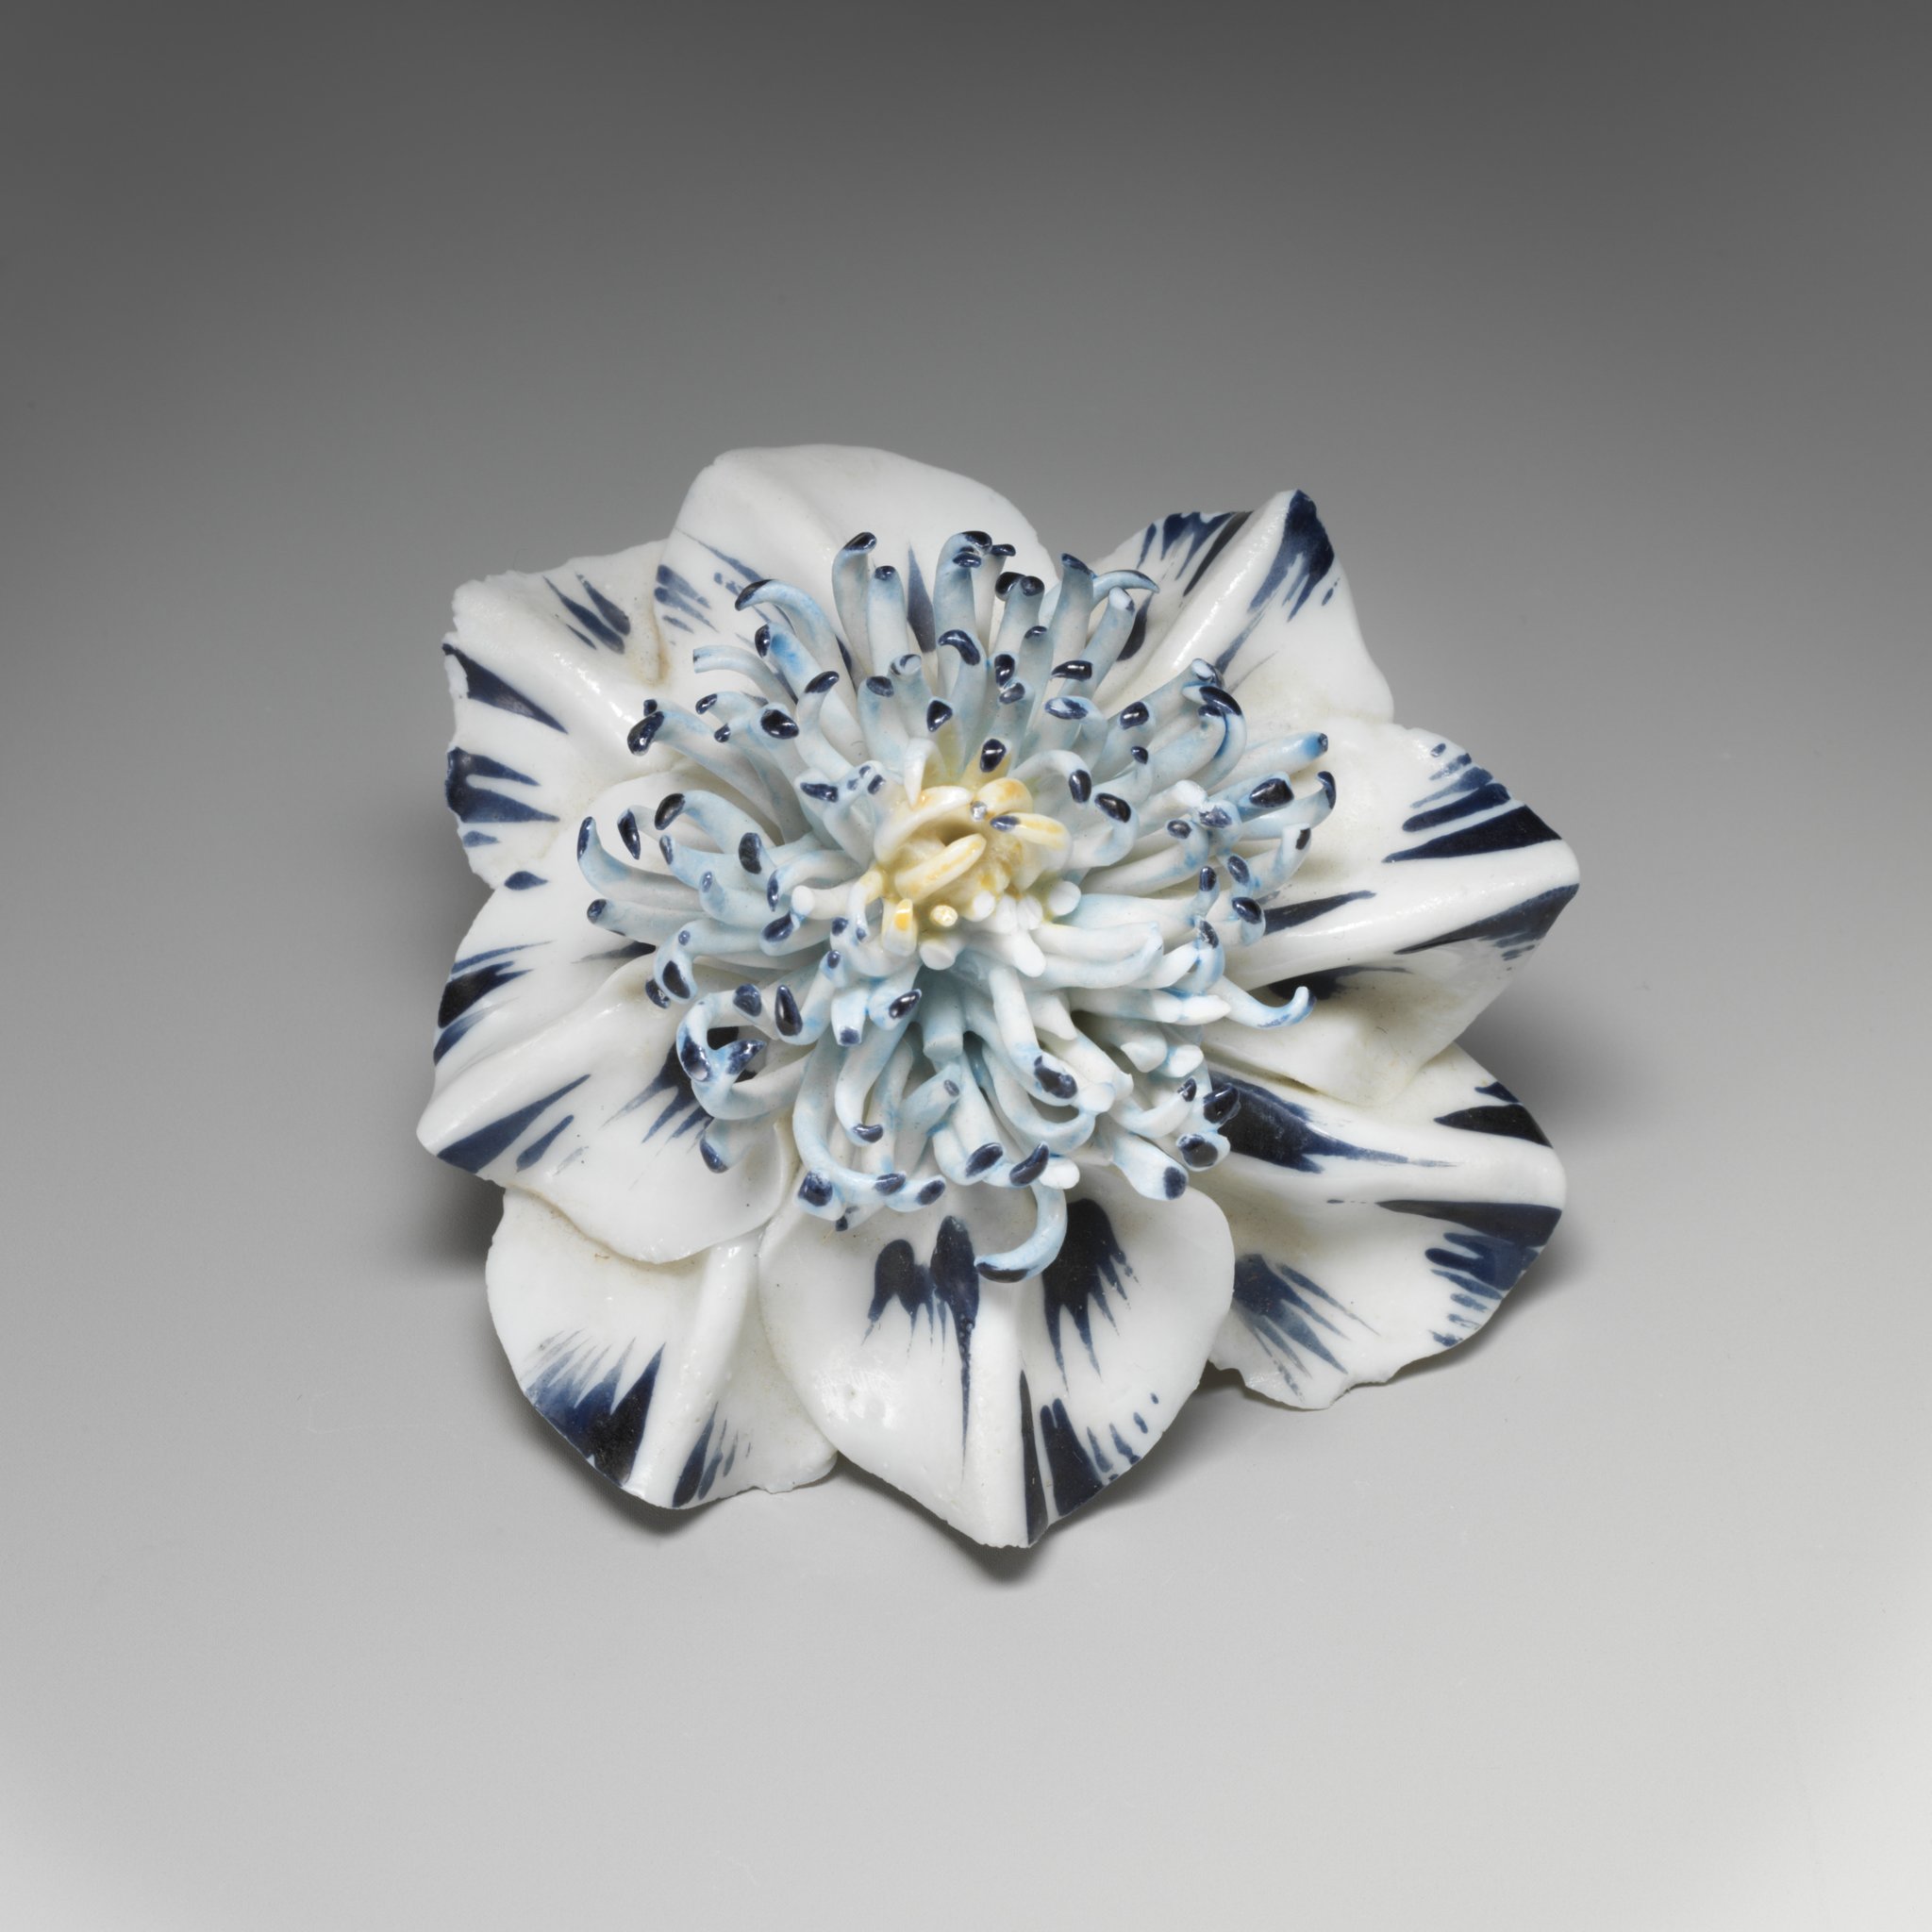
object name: flower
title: Porcelain flower (one of a set of nine)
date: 1734-1766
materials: soft paste porcelain